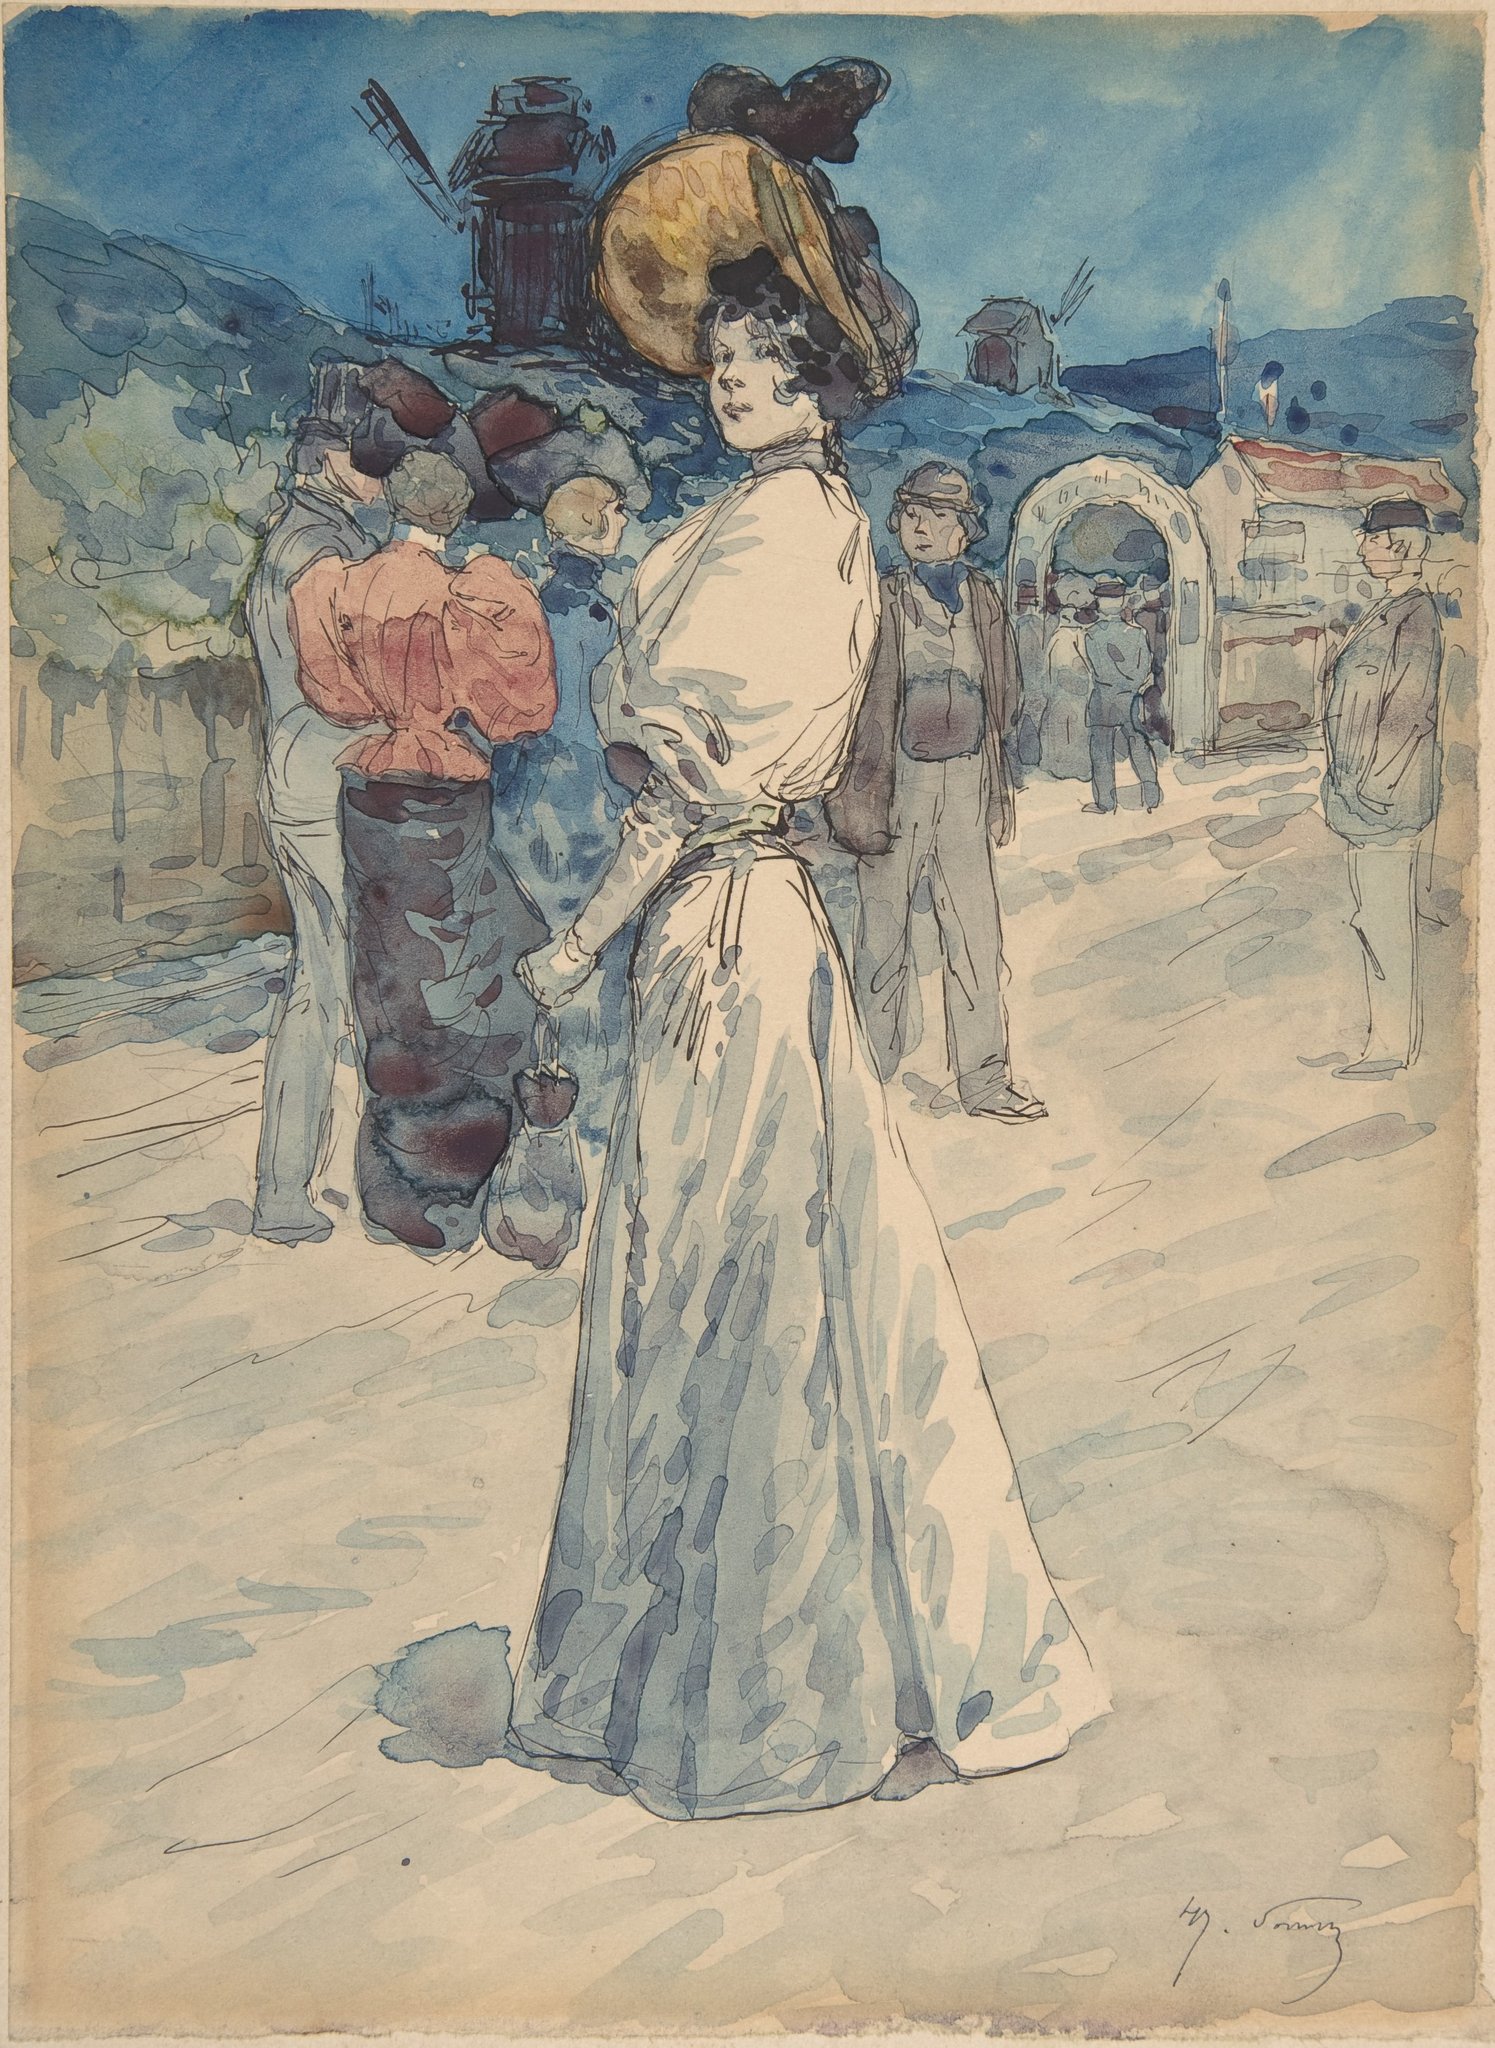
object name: drawing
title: A Parisienne Outside the Moulin de la Galette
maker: henri somm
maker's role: artist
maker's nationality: french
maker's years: 1844-1907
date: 1844-1907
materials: graphite, ink, watercolor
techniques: pen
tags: buildings,men,women